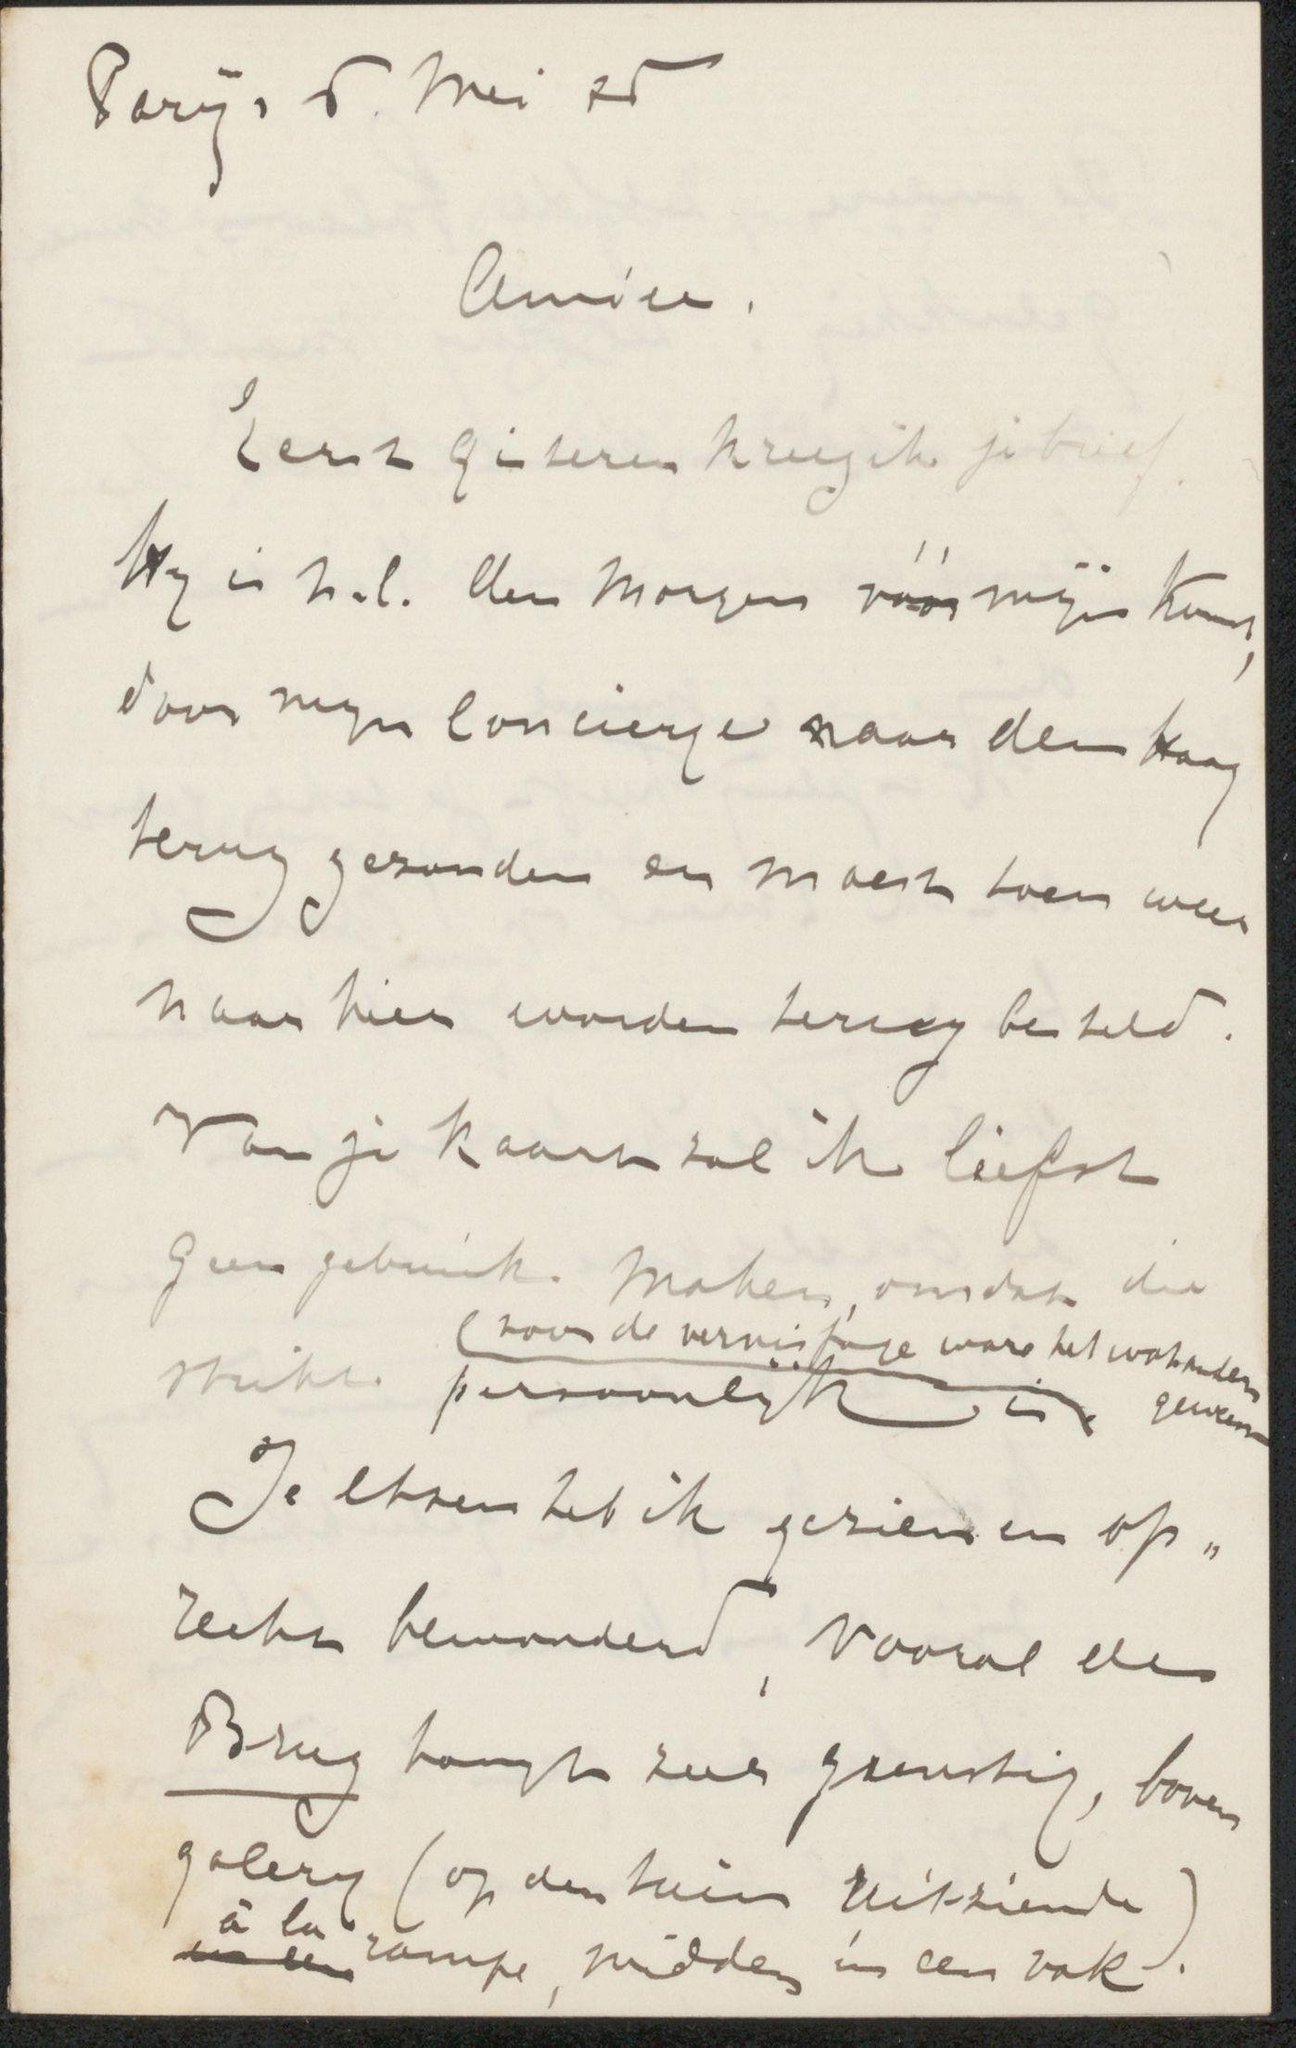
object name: letter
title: Brief aan Philip Zilcken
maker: adriaan pit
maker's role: print maker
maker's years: 1860-1944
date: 1886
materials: ink, paper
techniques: pen, writing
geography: paris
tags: marinus van der maarel, isaac israels, elbert jan van wisselingh, the hague, painter, draughtsman, philip zilcken, the graphic arts, exhibition ~ art, printed matter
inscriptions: collector's mark: ‘RPK’